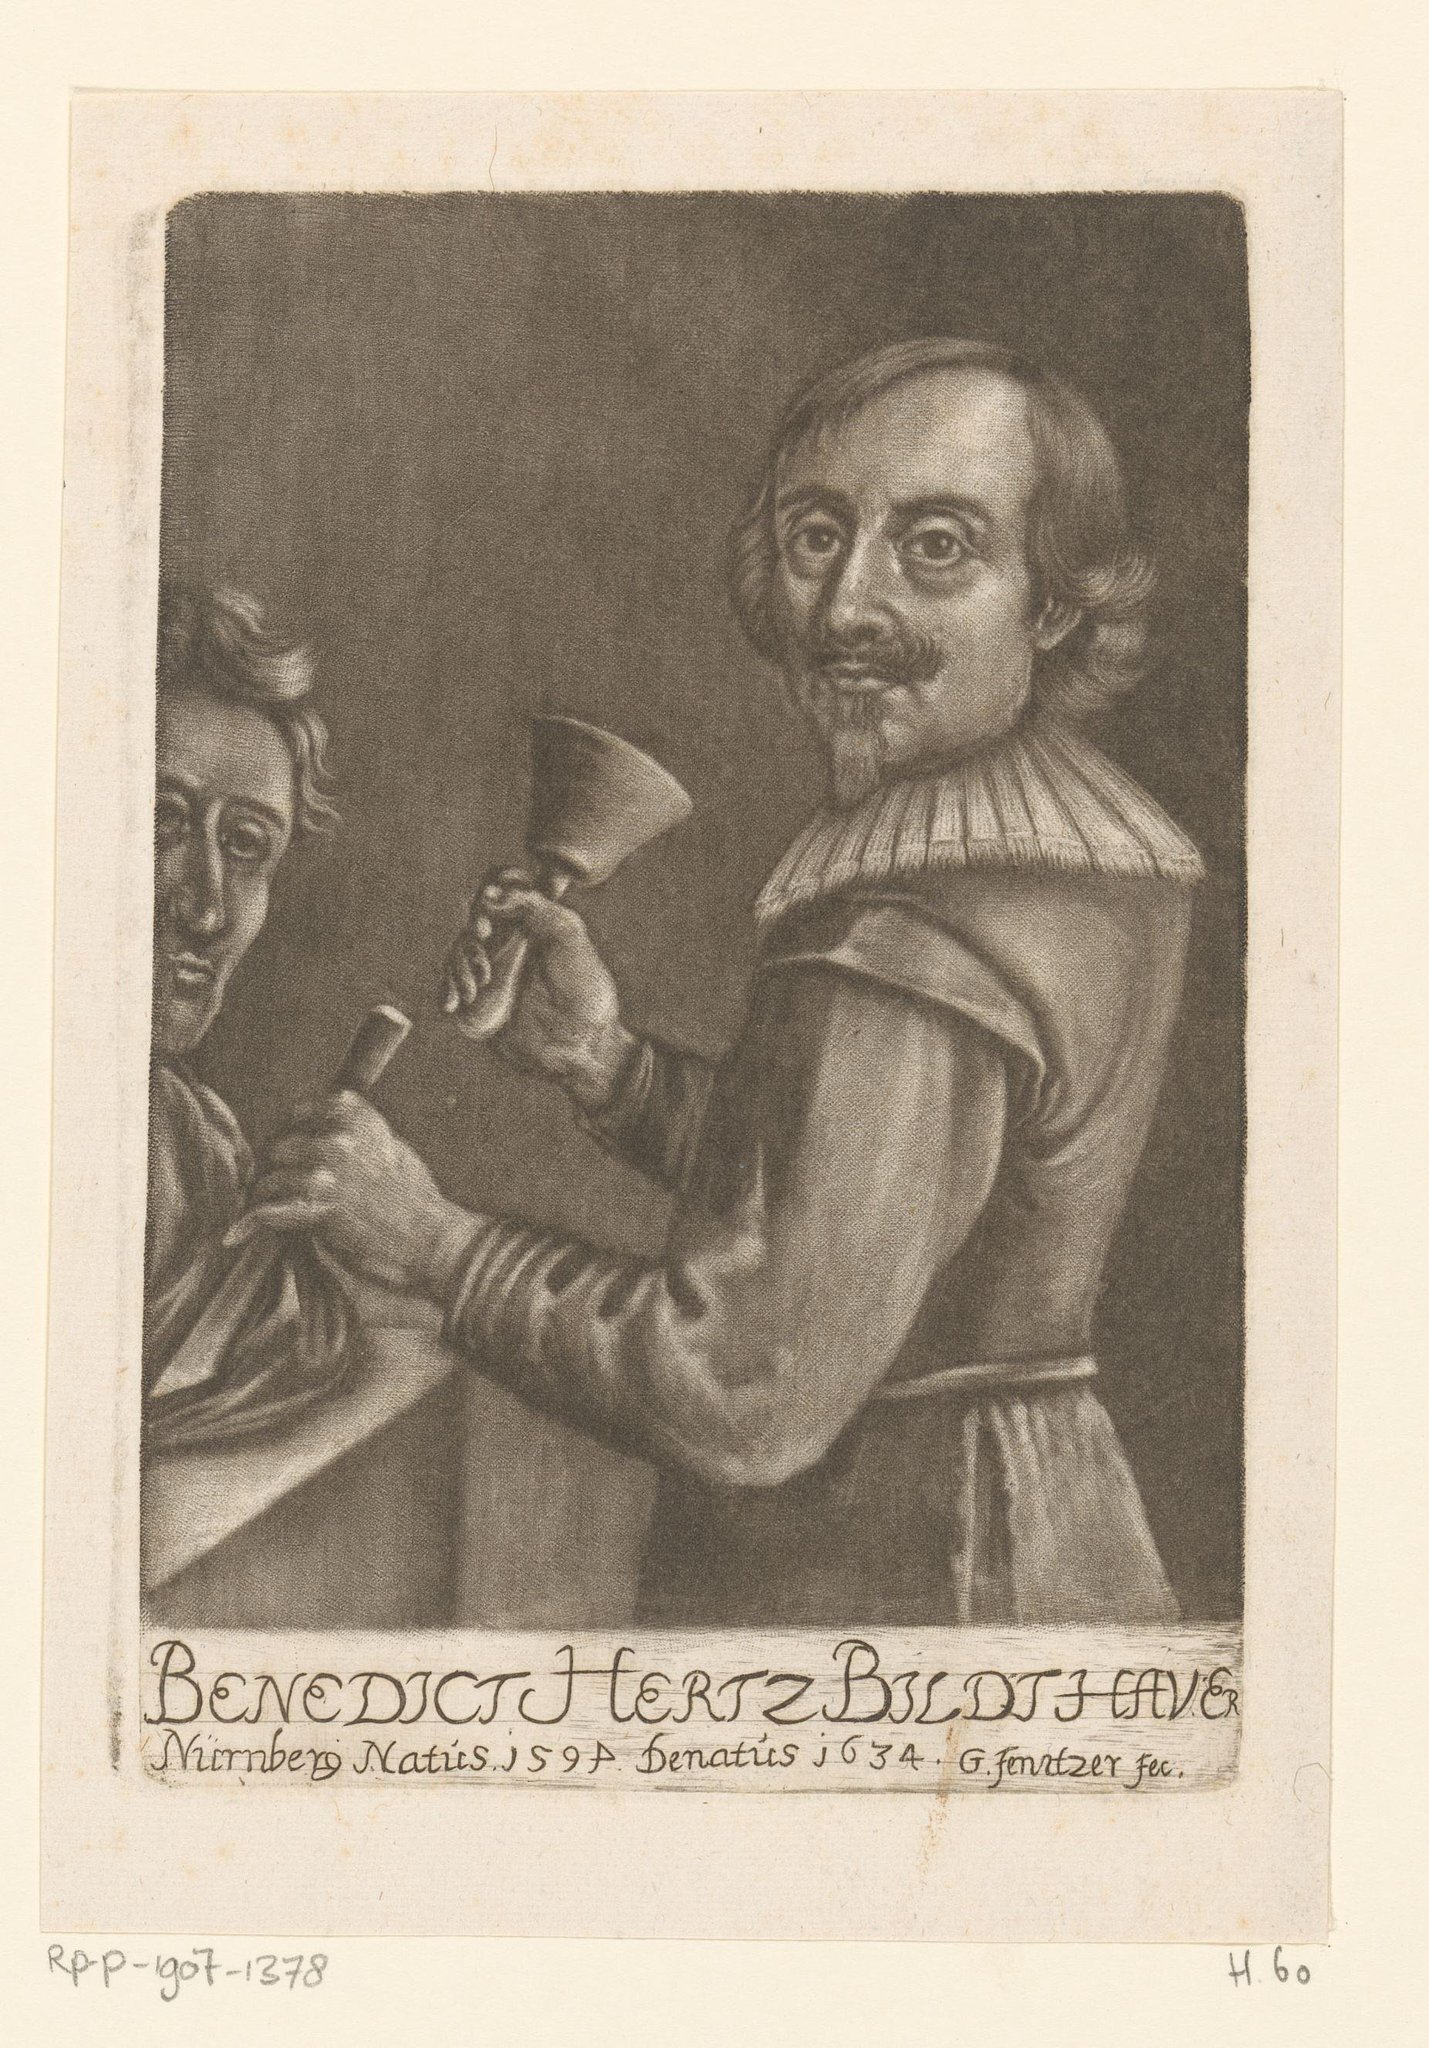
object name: print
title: Portret van Benedikt Hertz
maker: georg fennitzer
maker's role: print maker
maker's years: 1646-1722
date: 1656-1722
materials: paper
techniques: mezzotint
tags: sculptor, portrait, self-portrait of sculptor, historical persons, tools, implements of sculptor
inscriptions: collector's mark: Lugt 2228